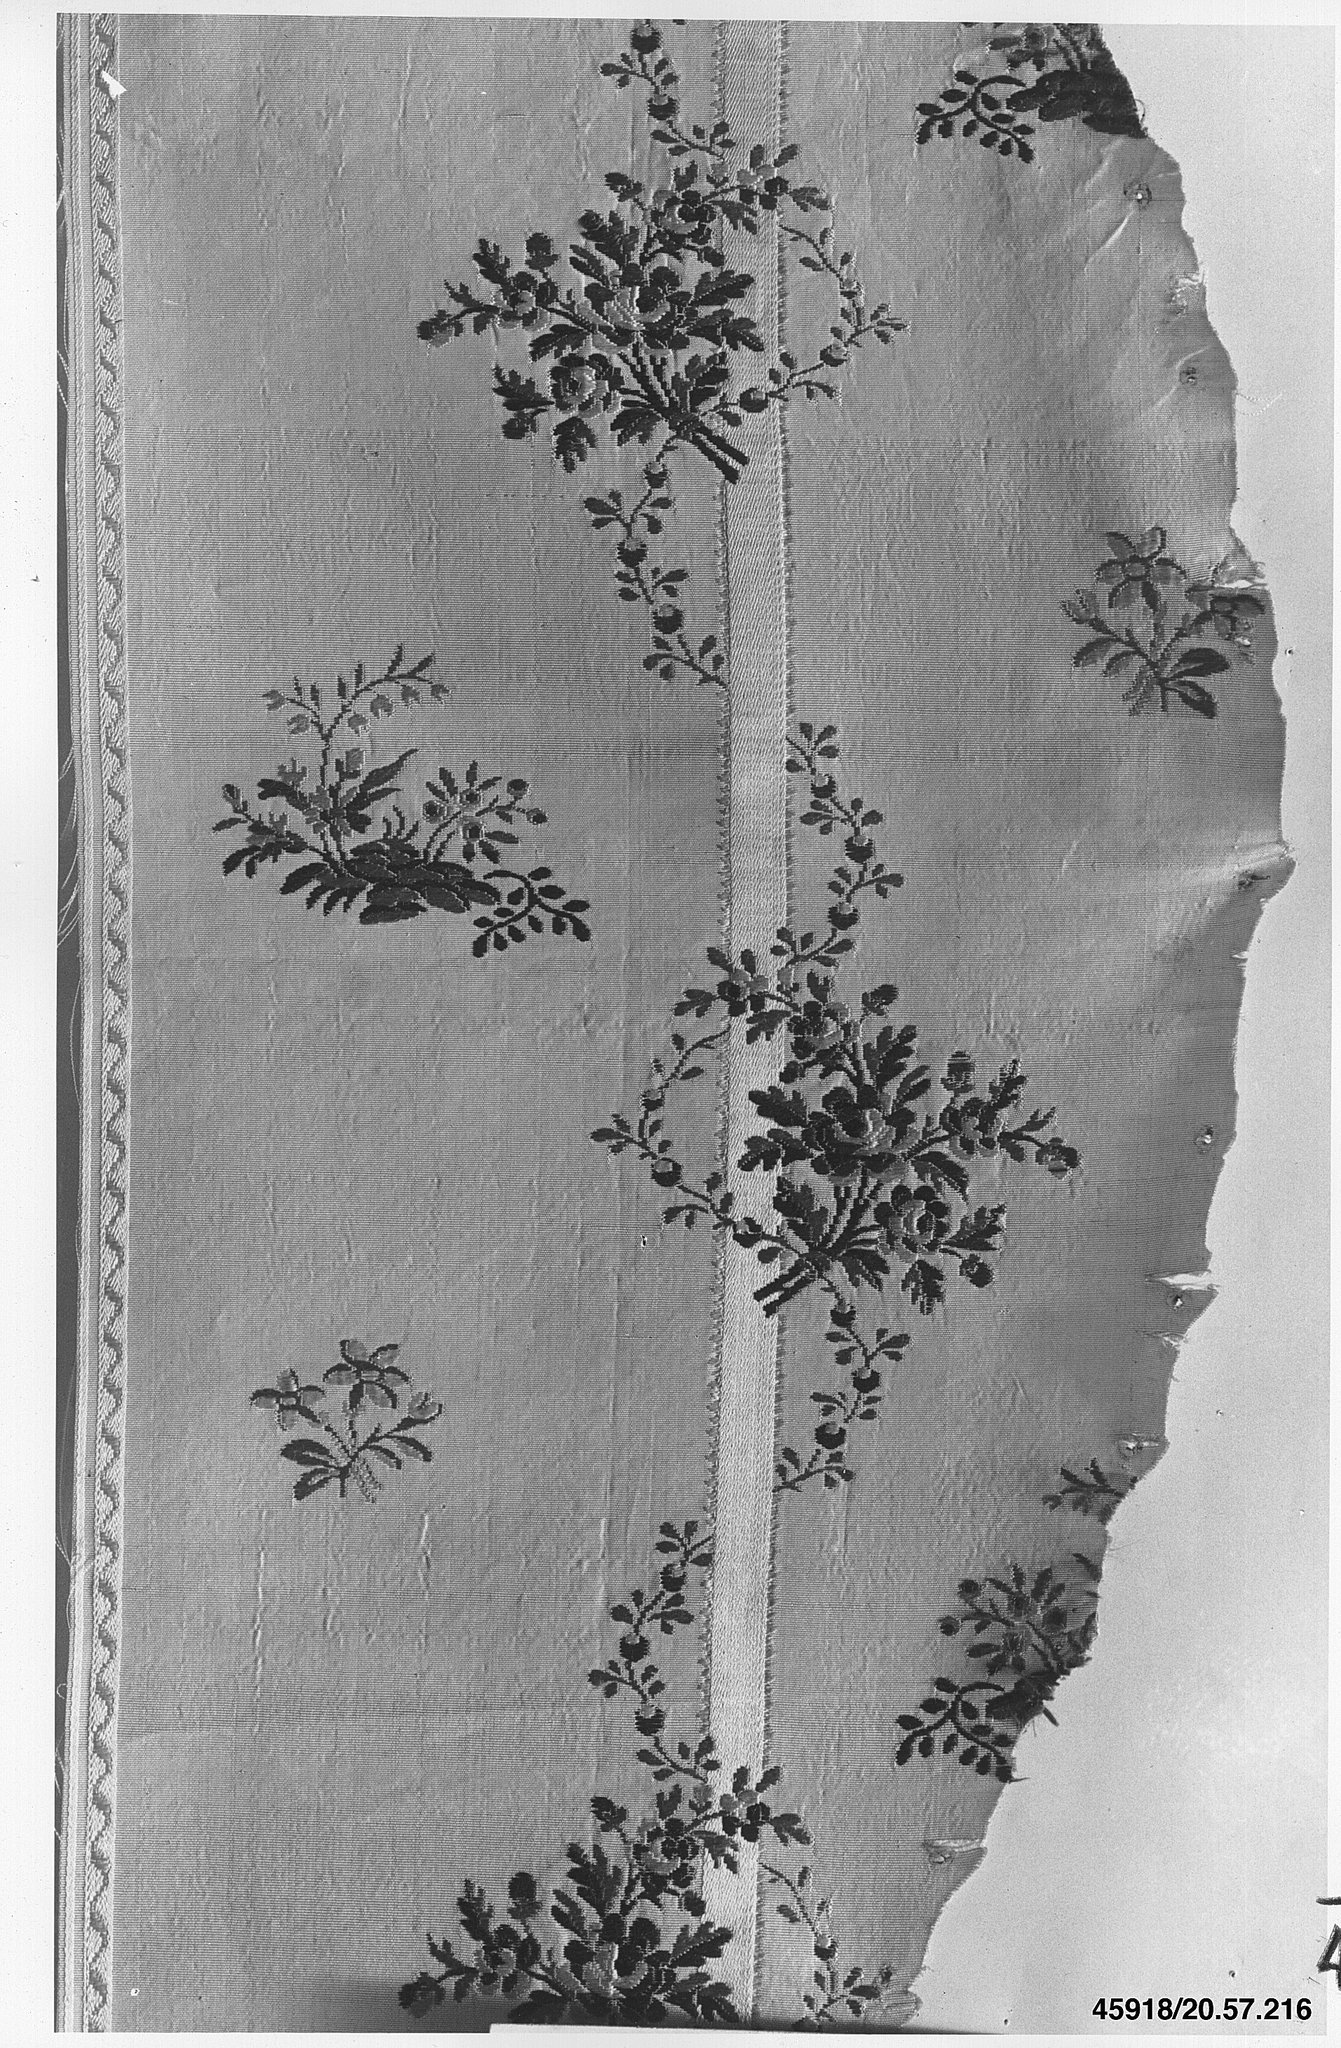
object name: piece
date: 1775-1800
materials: silk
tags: plants,leaves